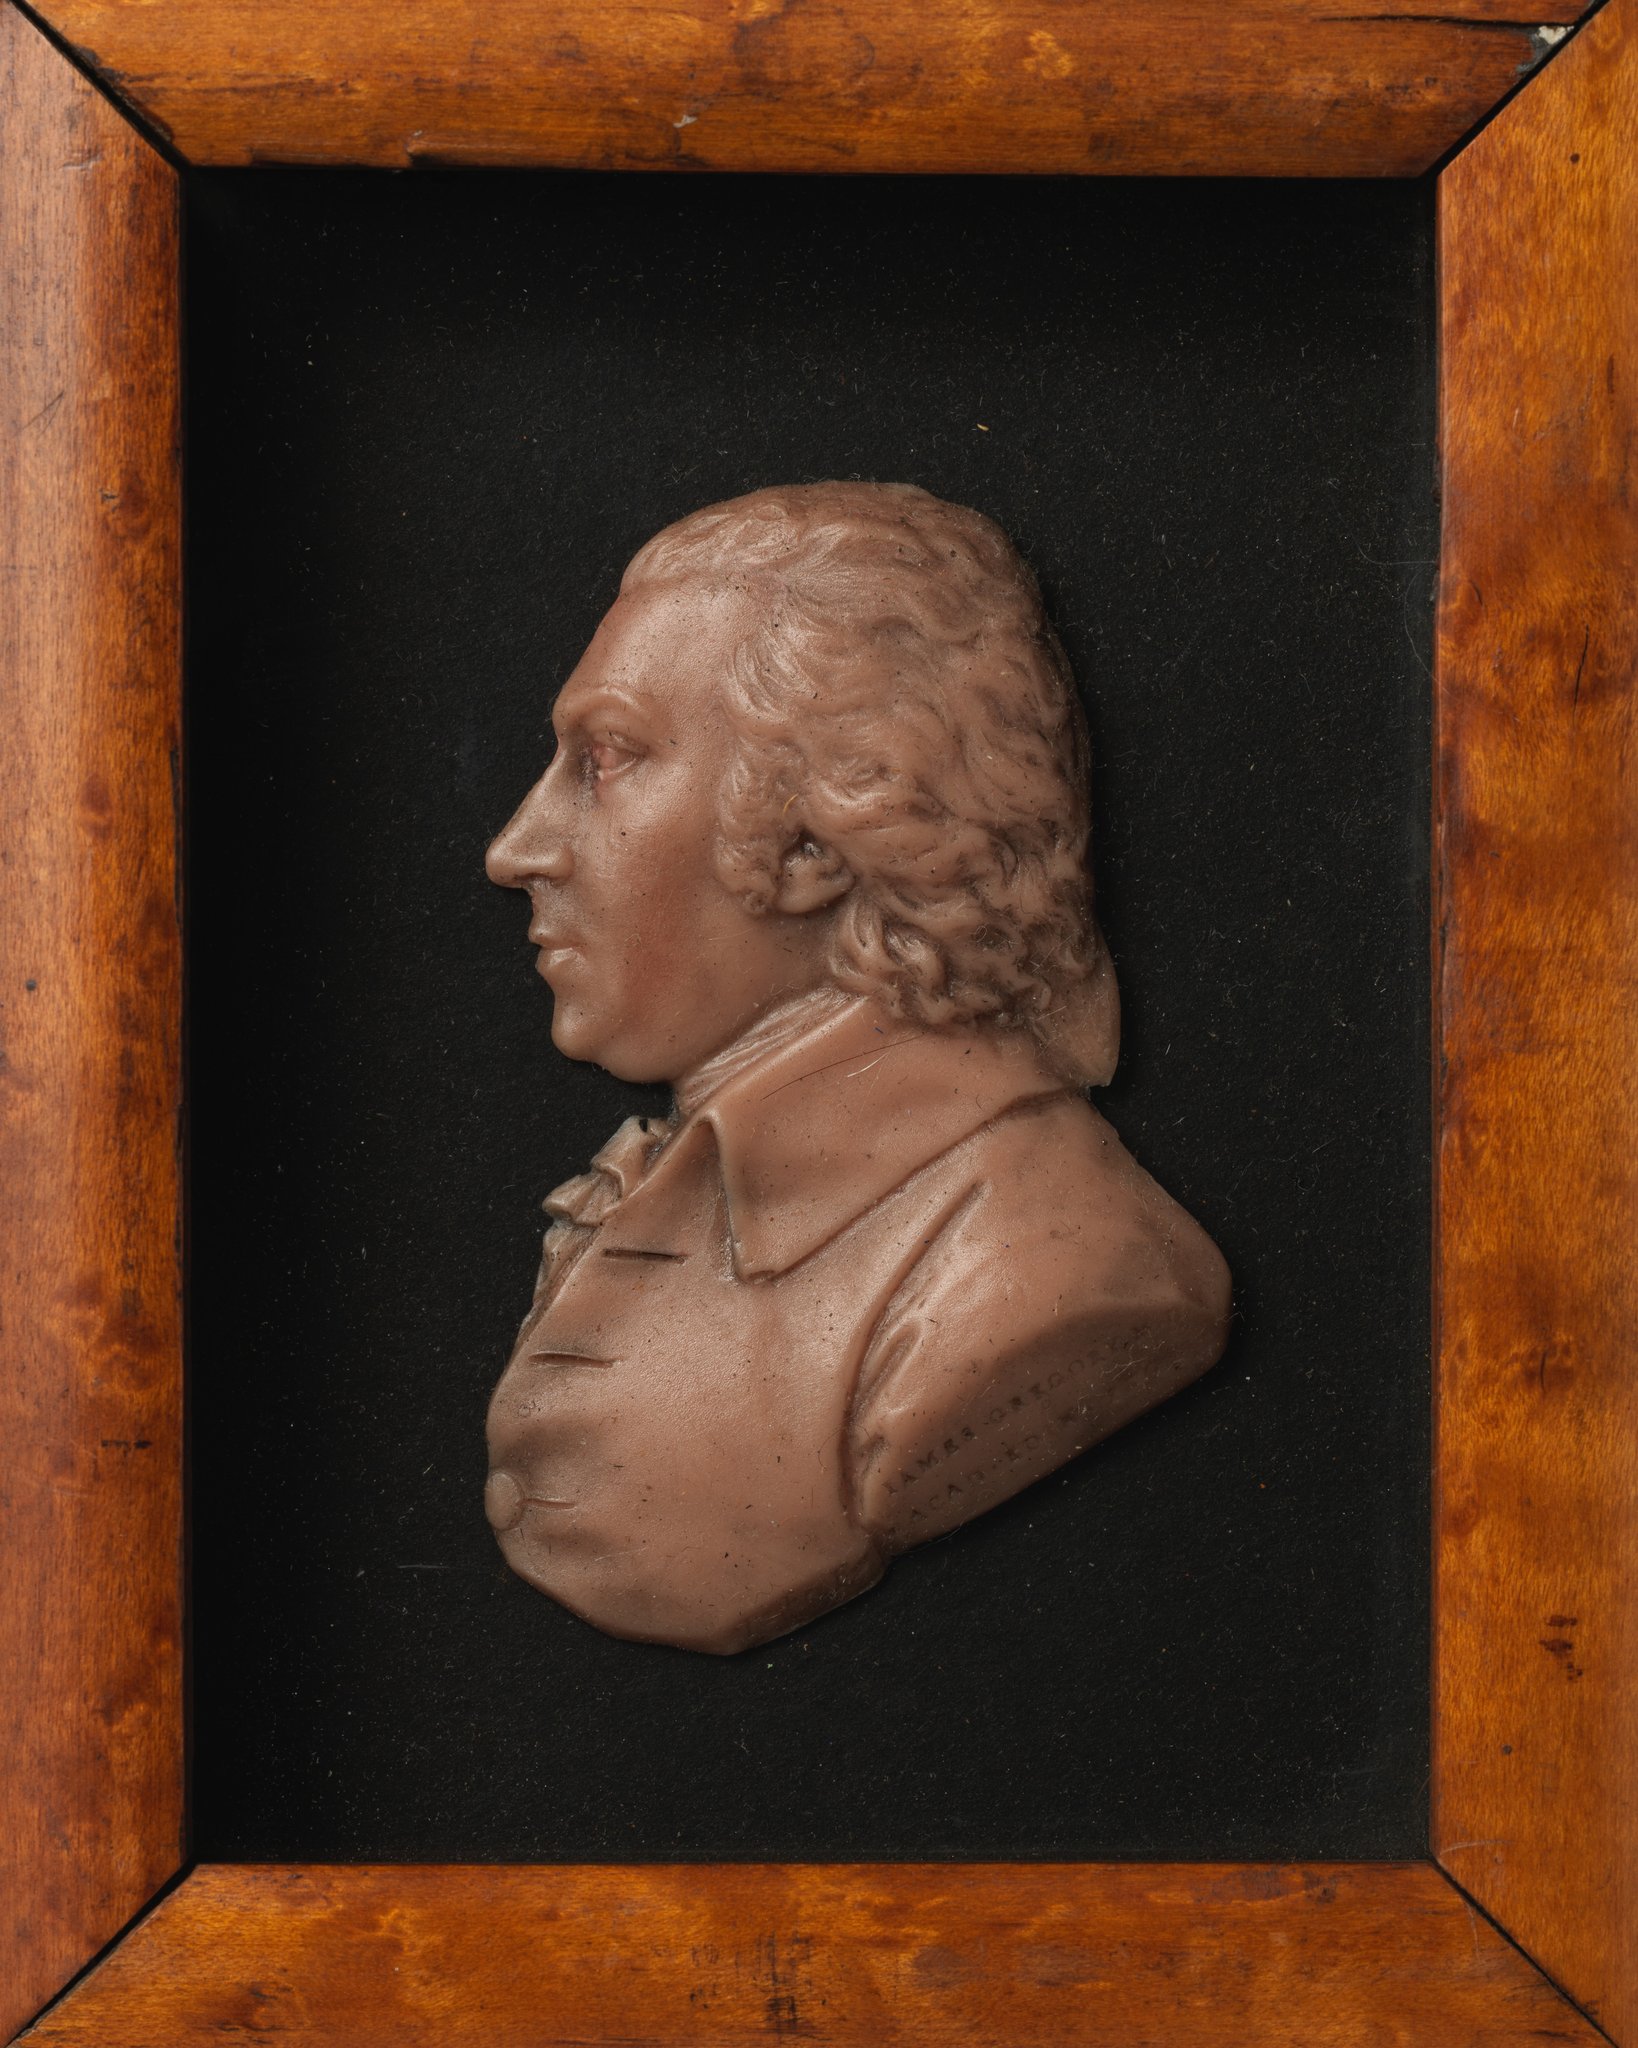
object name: relief bust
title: James Gregory, M.D. (1753–1821)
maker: james tassie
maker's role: artist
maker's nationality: british, scottish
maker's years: 1735-1799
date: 1791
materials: board, wax, wood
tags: men,profiles